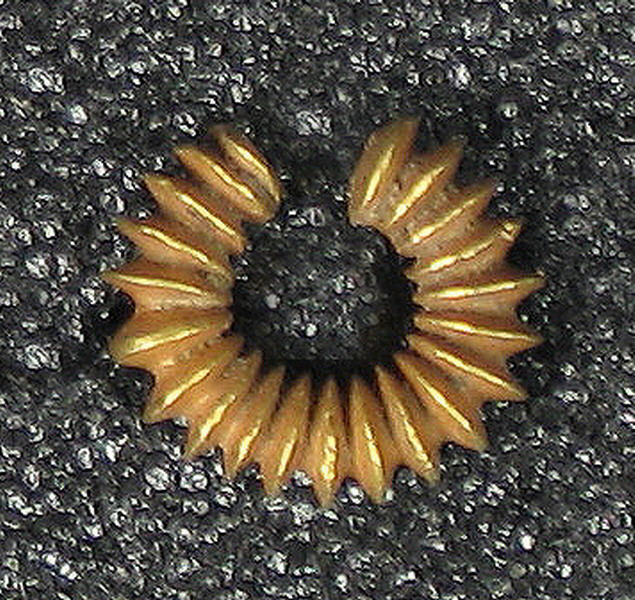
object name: earring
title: One of a Set of Four Earrings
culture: indonesian, central java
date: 701-1200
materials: gold